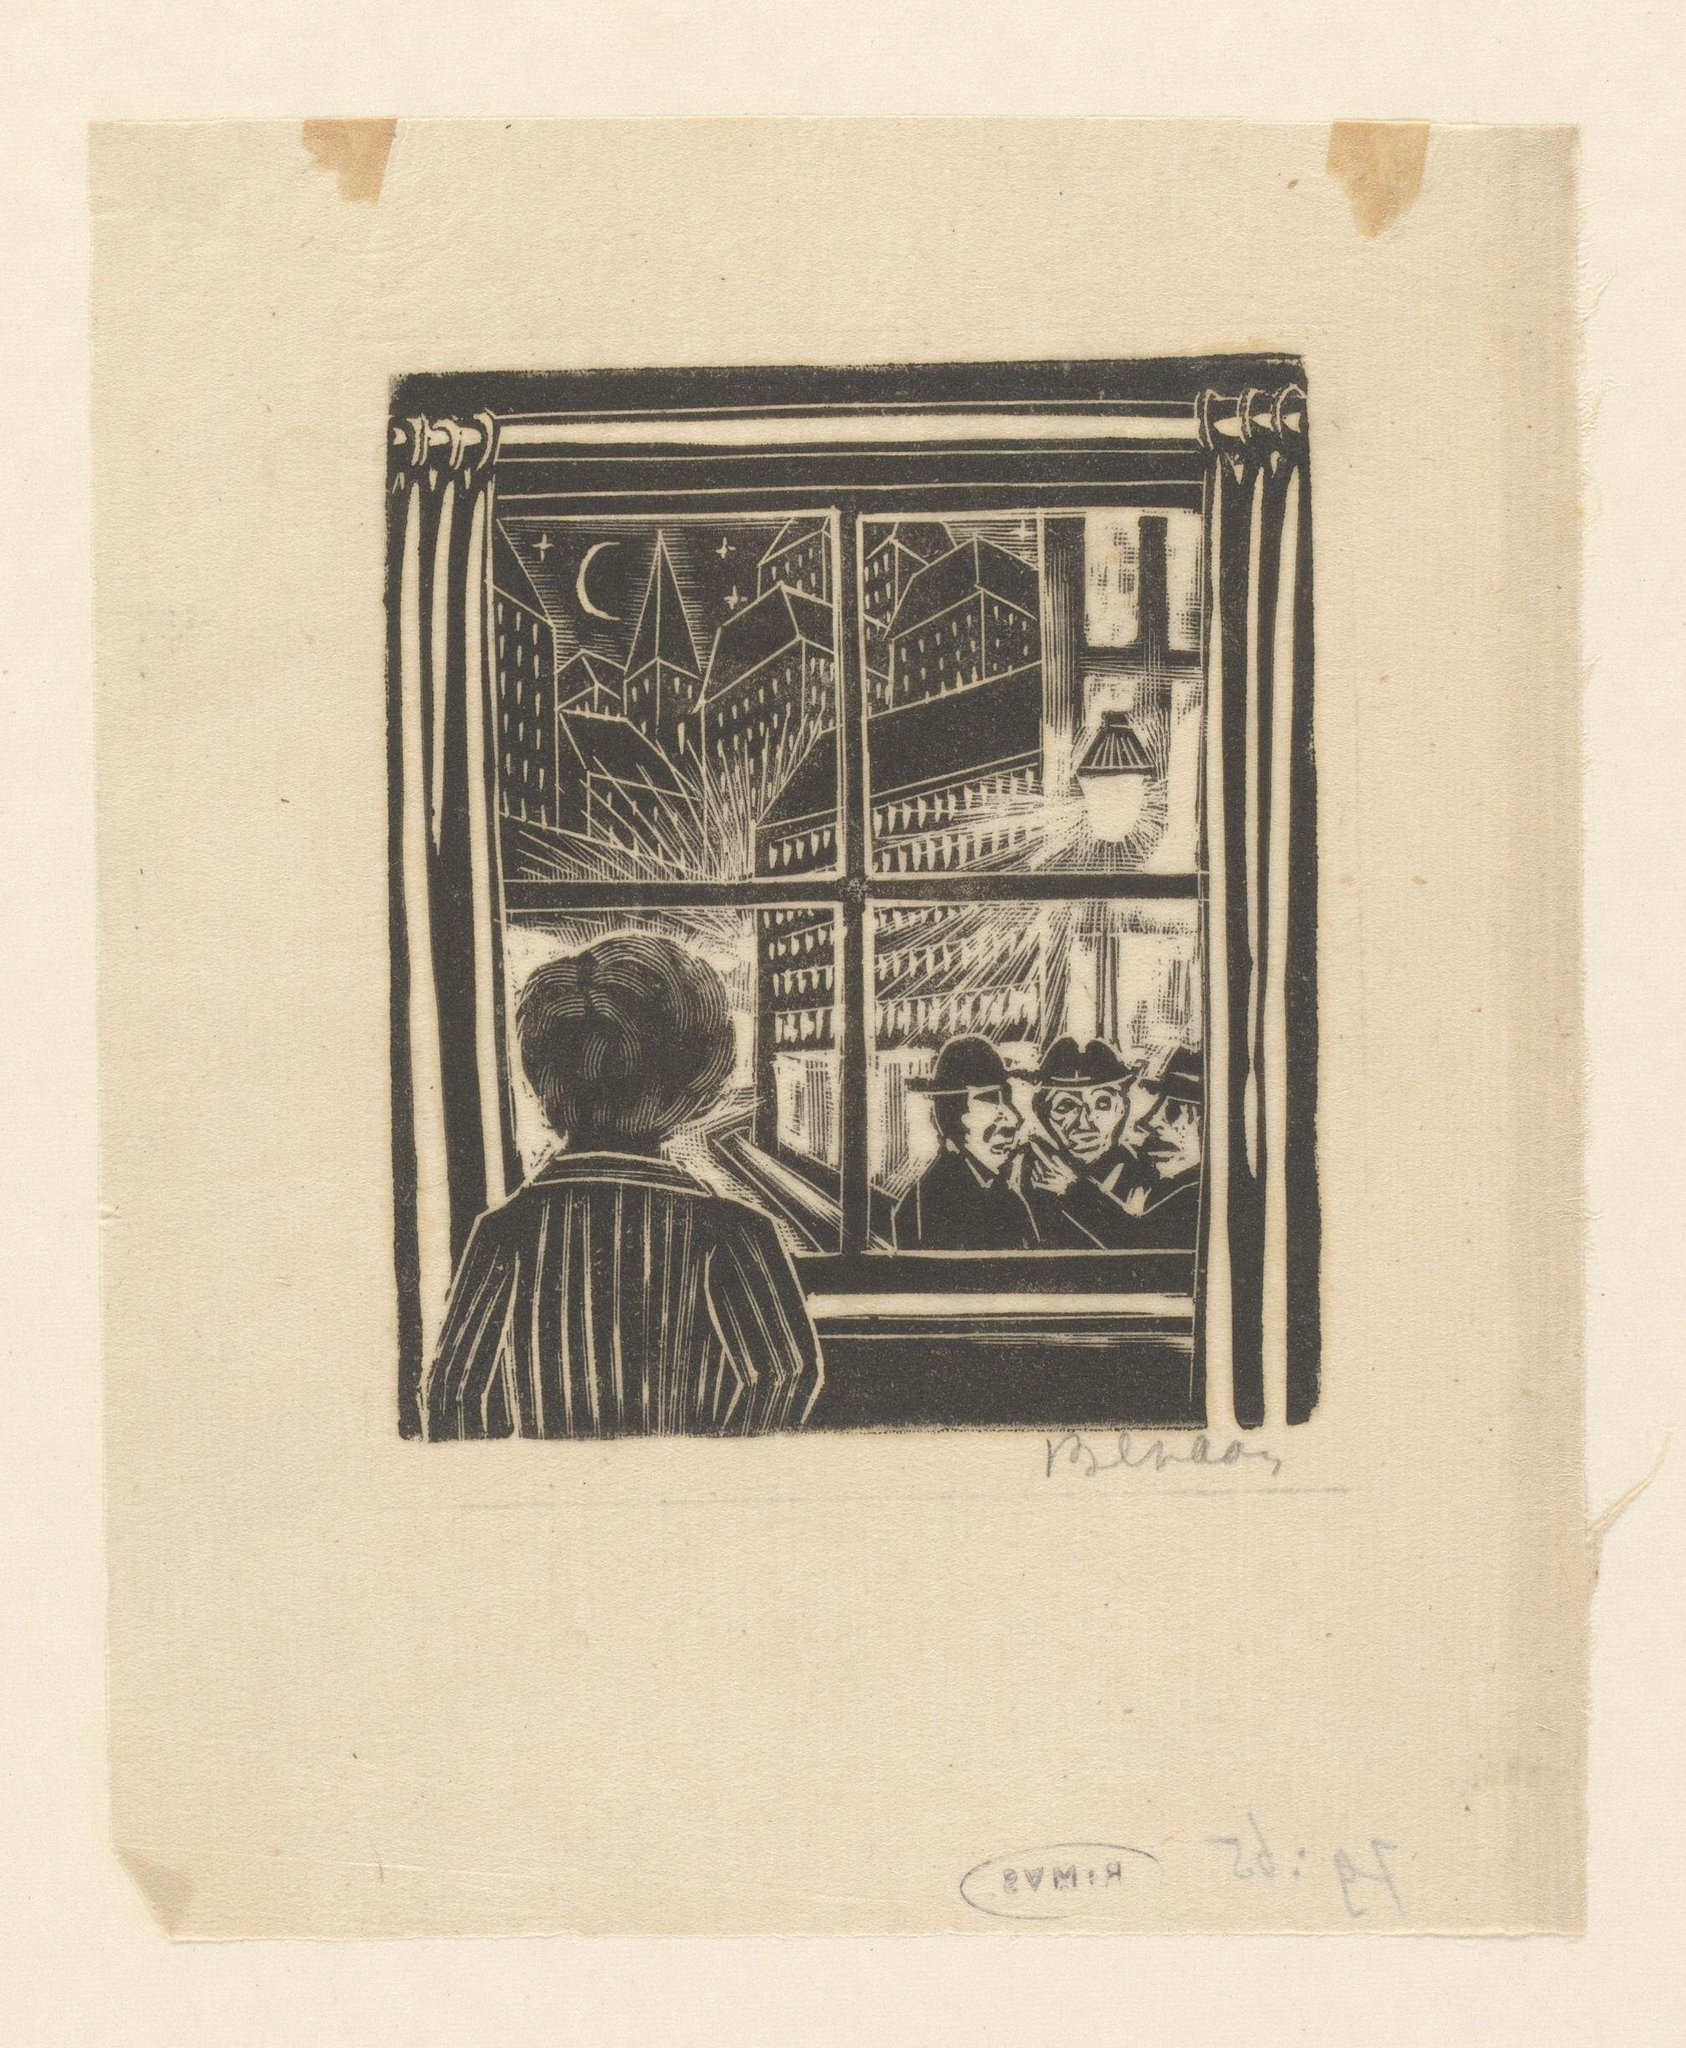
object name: print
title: Drie mannen op straat bekeken van achter een raam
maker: jo bezaan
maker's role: draughtsman, print maker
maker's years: 1894-1952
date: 1904-1952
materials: paper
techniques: engraving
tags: conversation, dialogue; conversation piece, human figure at (open) window, seen from inside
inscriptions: collector's mark: Lugt 2228